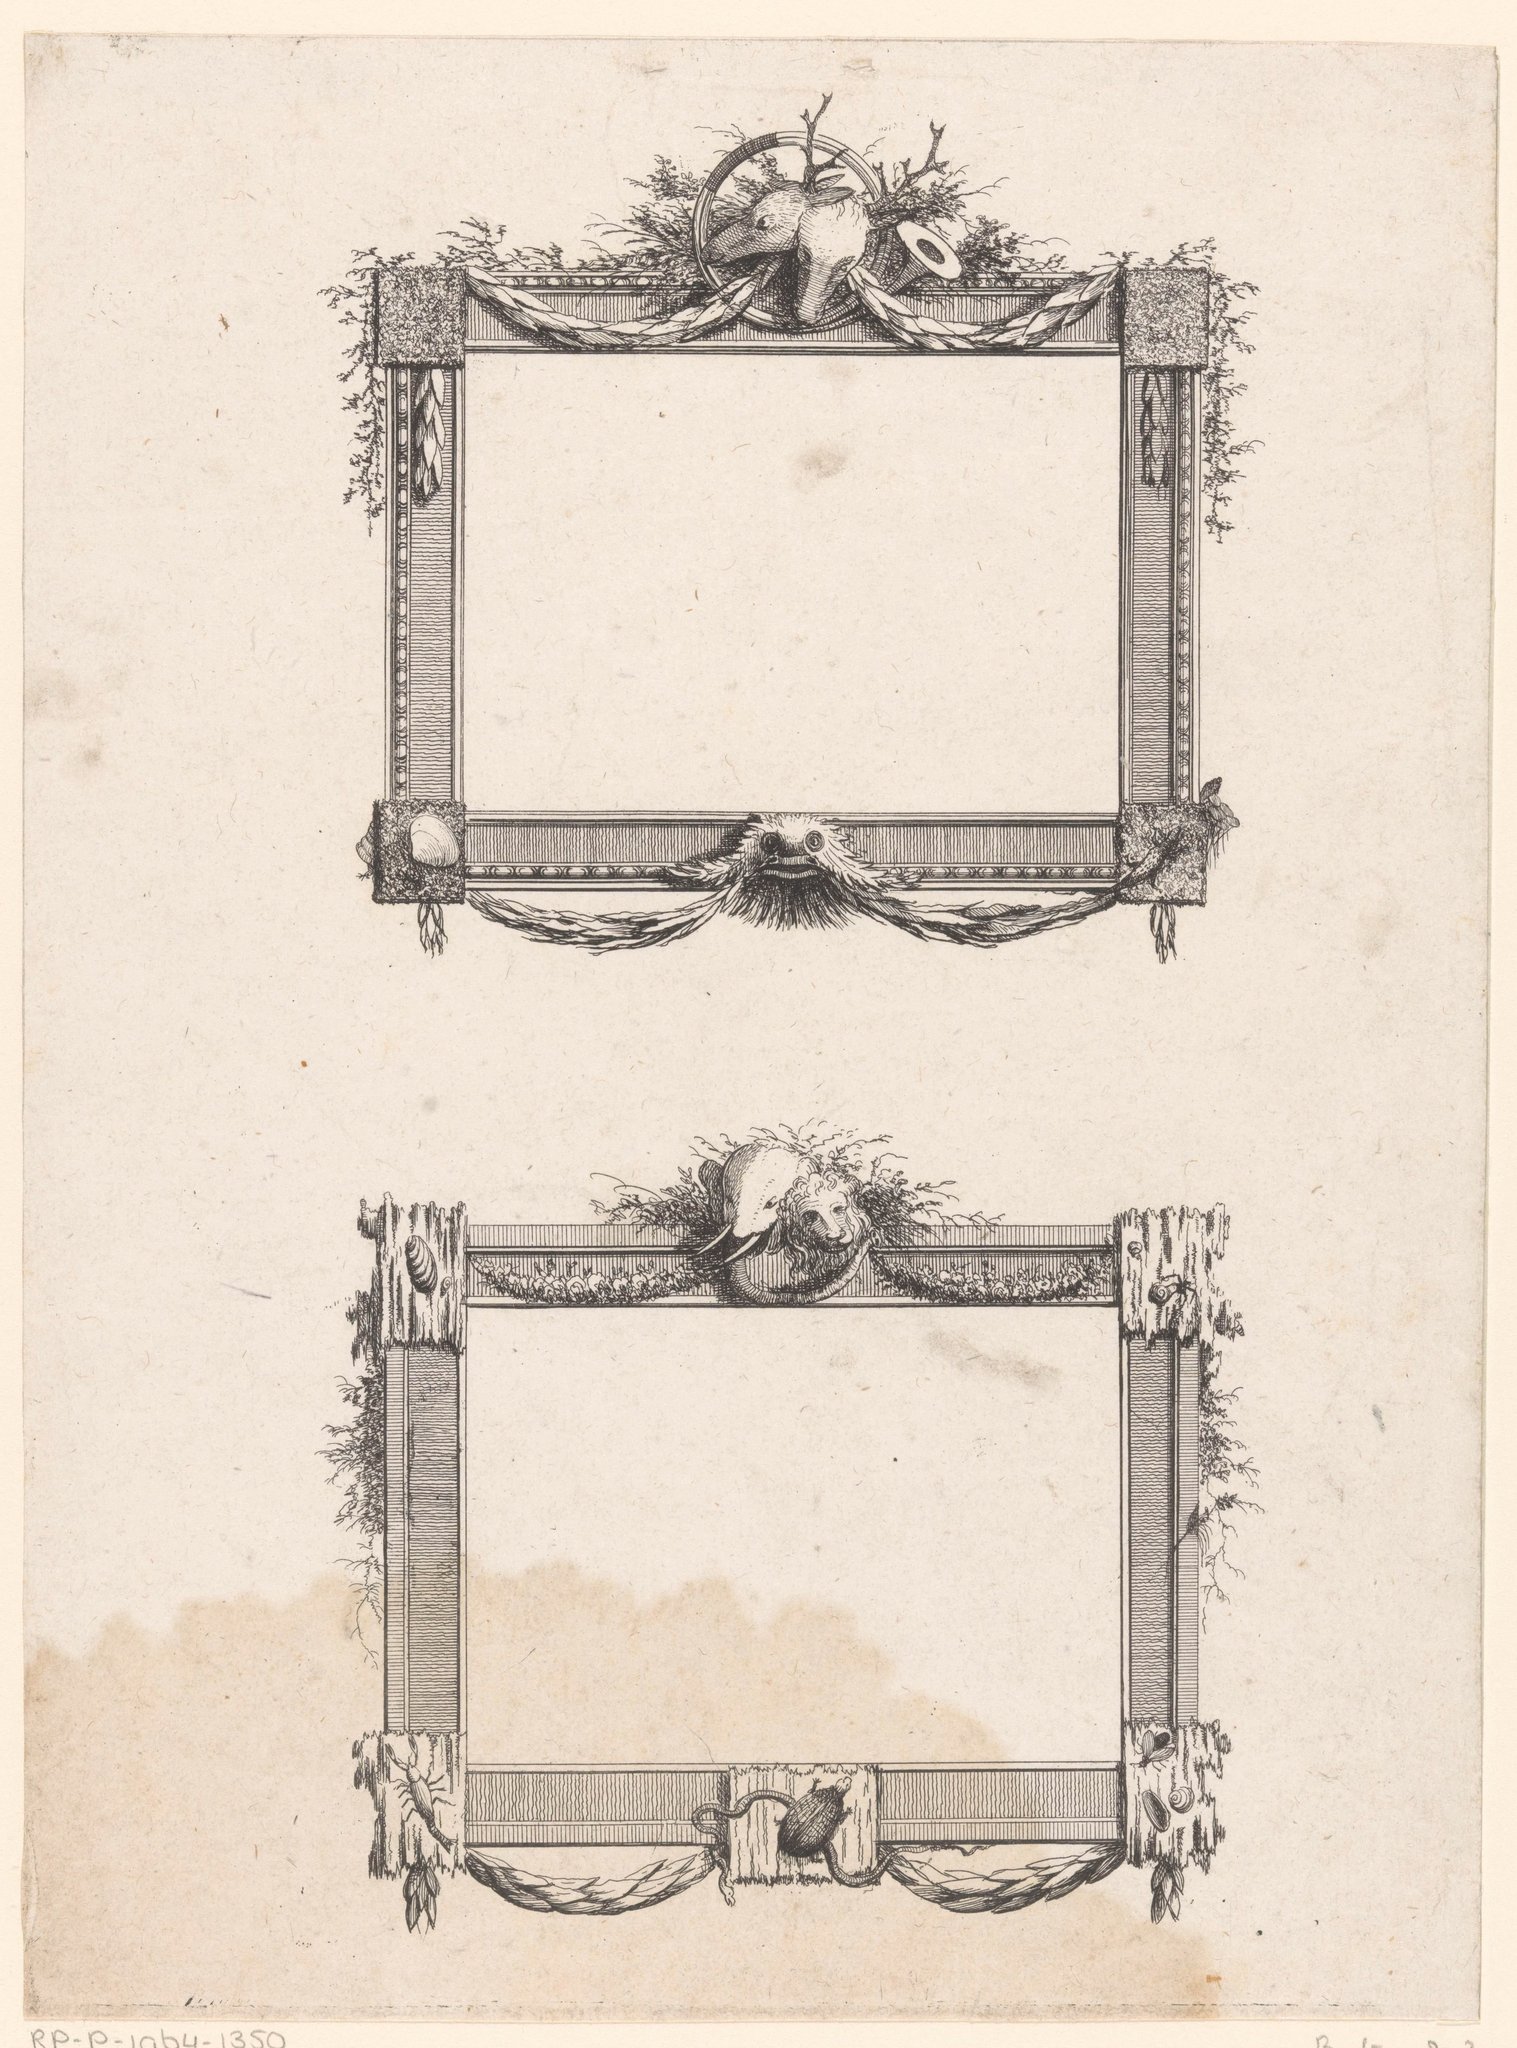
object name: ornament print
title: Omlijstingen met dieren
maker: johann thomas hauer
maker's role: print maker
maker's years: 1748-1820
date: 1758-1820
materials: paper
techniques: engraving, etching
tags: ornaments ~ art (+ framing decorations)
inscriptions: collector's mark: Lugt 2760, collector's mark: Lugt 2228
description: Twee rechthoekige omlijstingen met guirlandes, dierenkoppen, insecten en zeedieren.